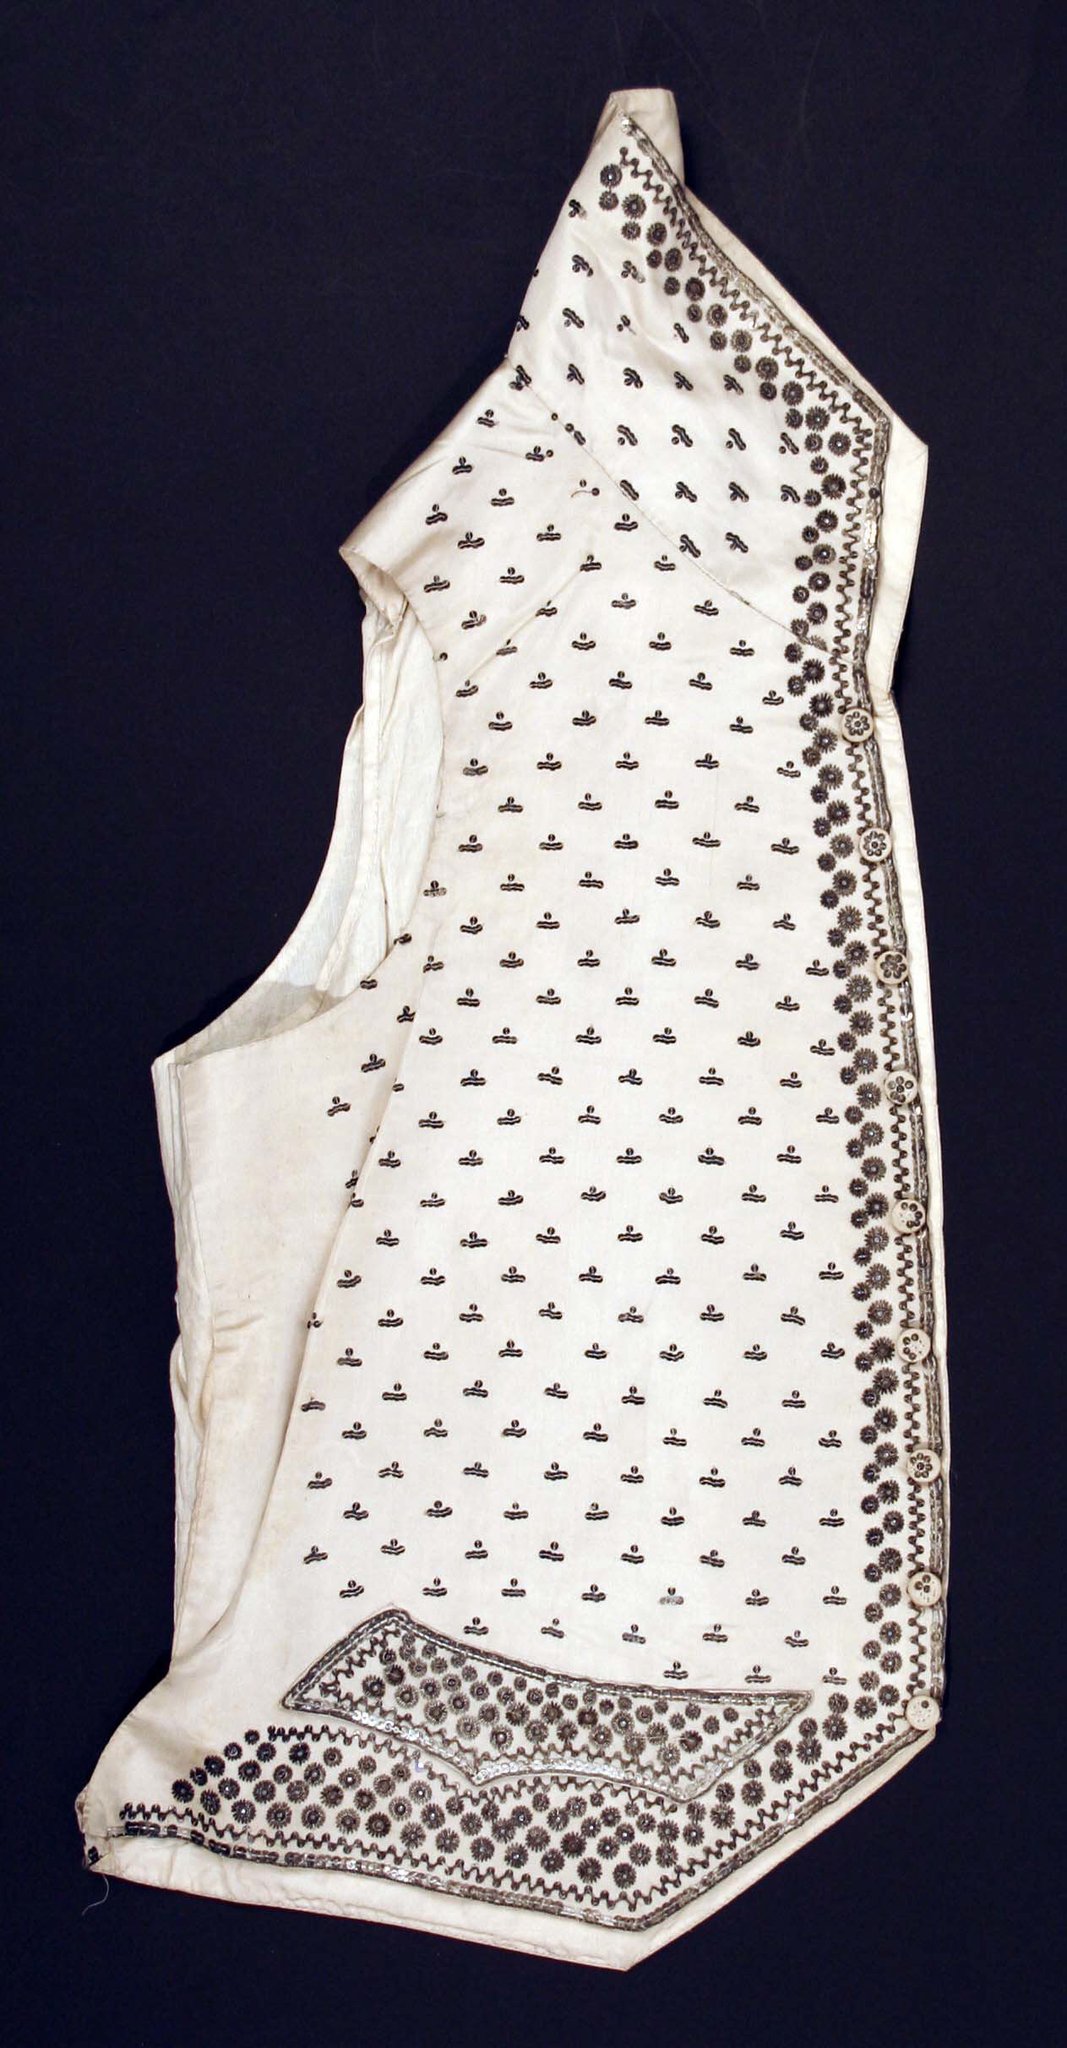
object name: waistcoat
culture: french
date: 1801-1833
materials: glass, metal, silk